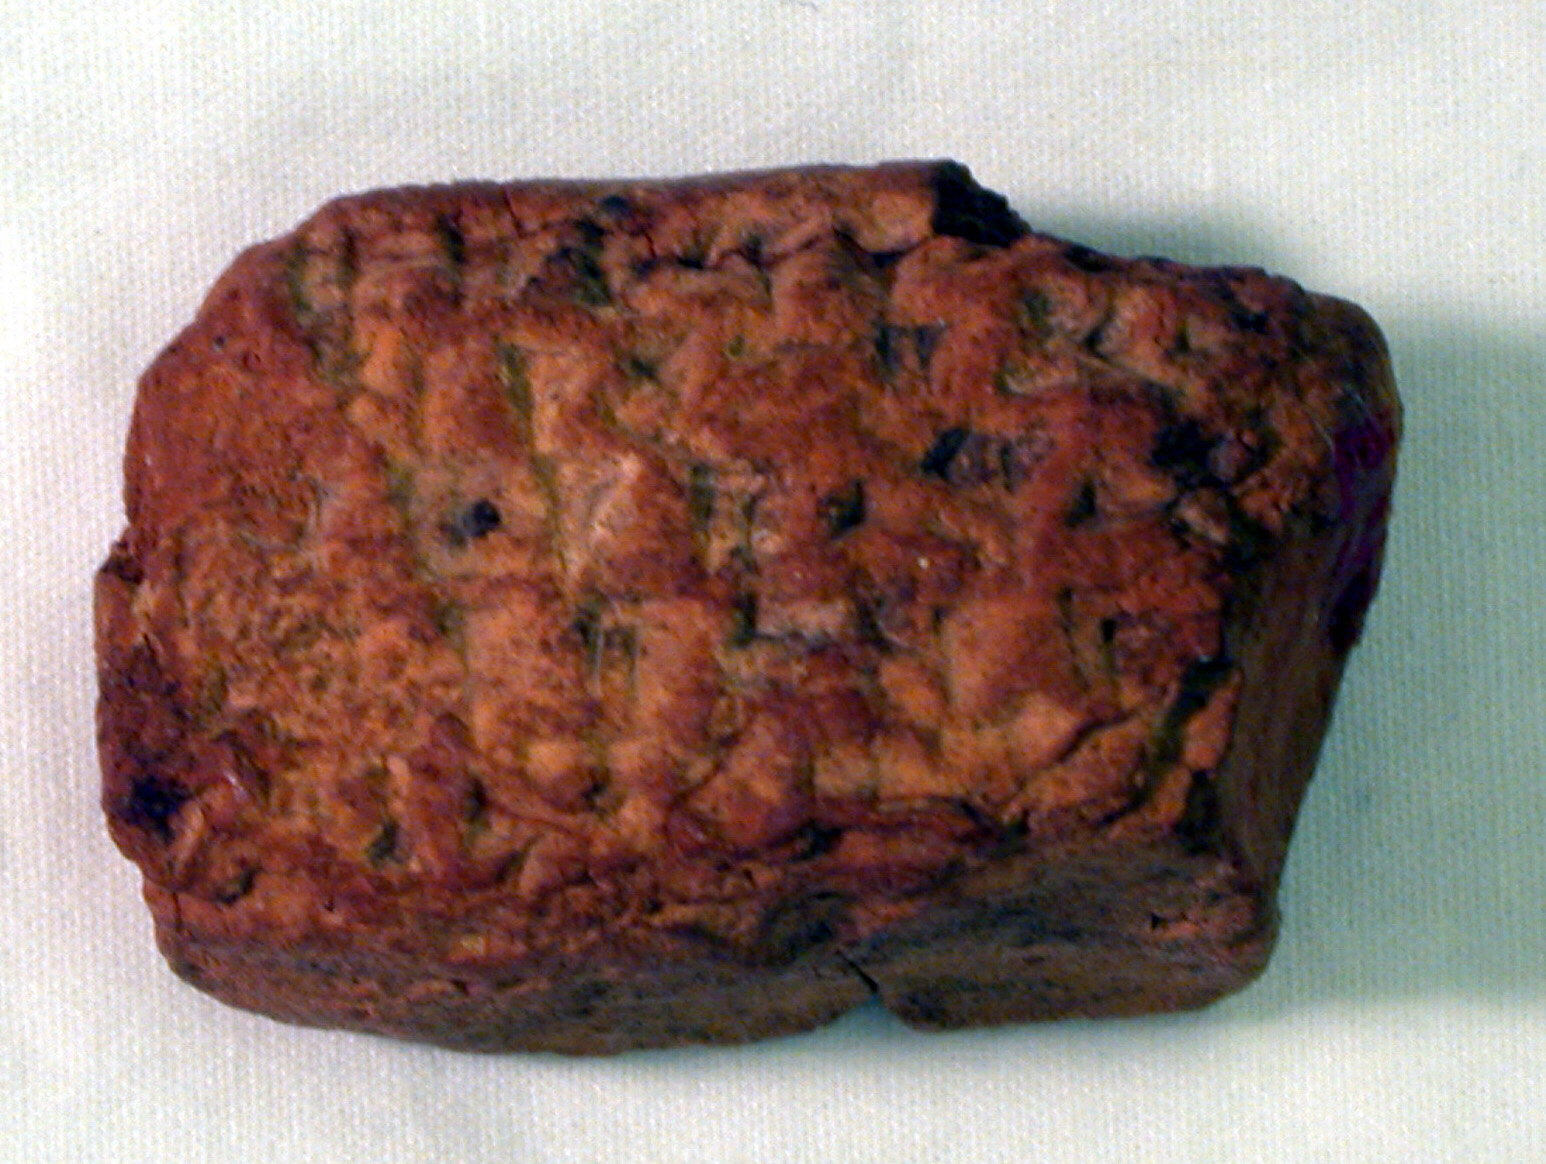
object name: cuneiform tablet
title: Cuneiform tablet: fragment of an account record (?)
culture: babylonian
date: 604-562 BCE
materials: clay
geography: mesopotamia